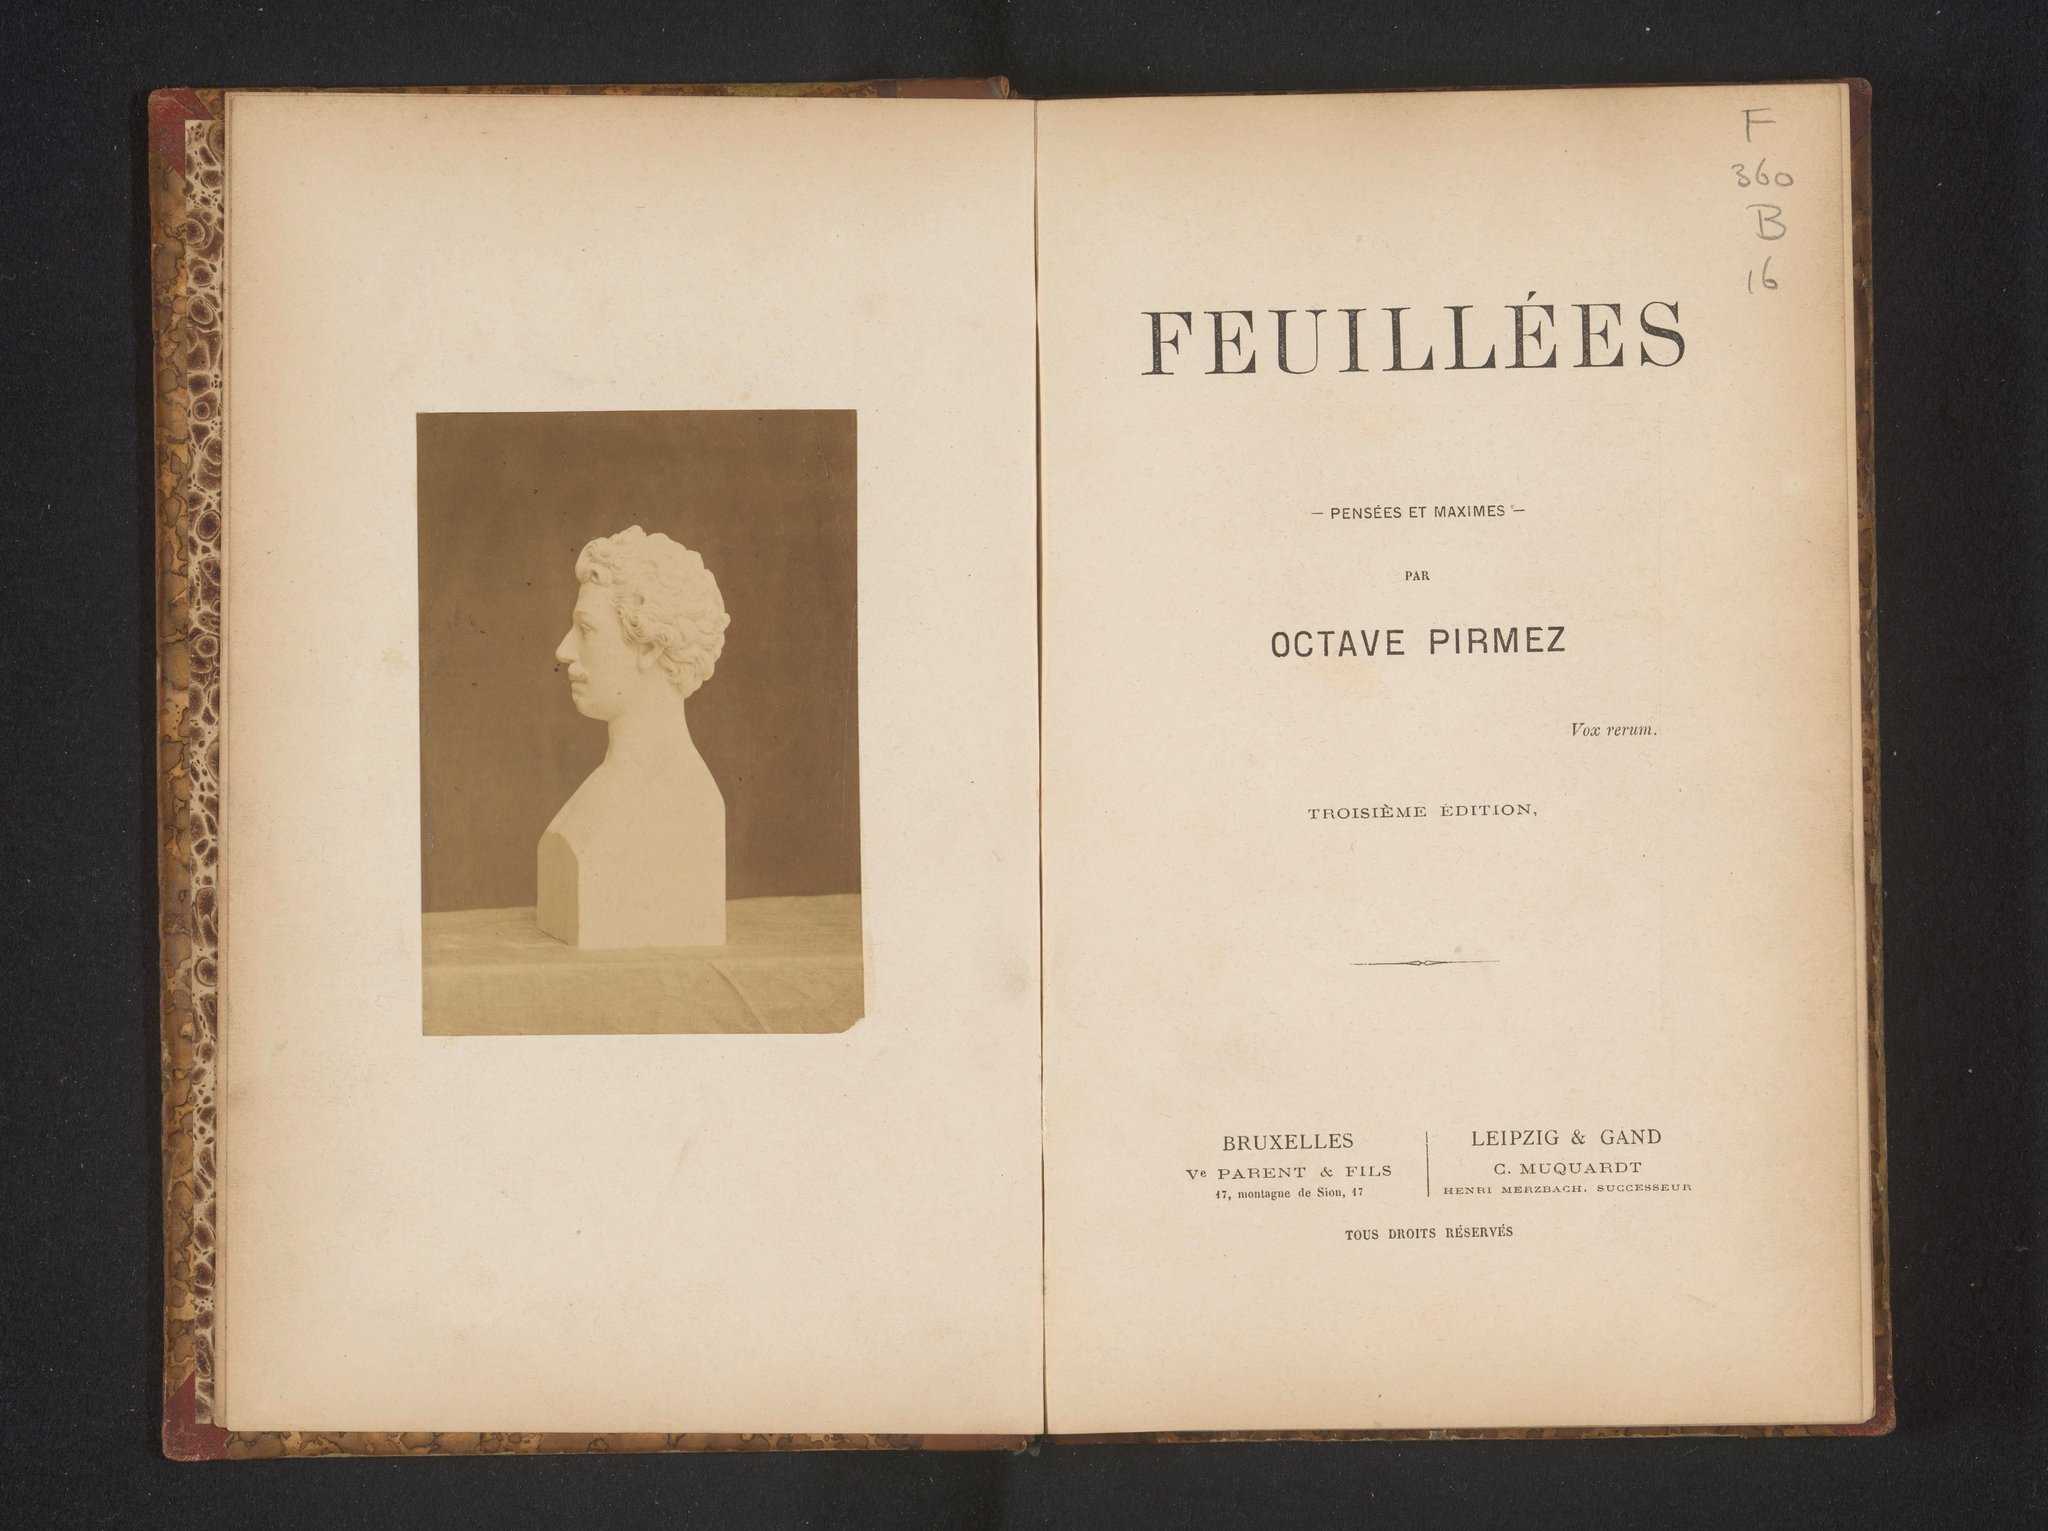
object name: photograph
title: Buste van Octave Pirmez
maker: Anonymous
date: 1870-1875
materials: photographic support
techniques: albumen print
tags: octave pirmez, historical persons, piece of sculpture, reproduction of a piece of sculpture